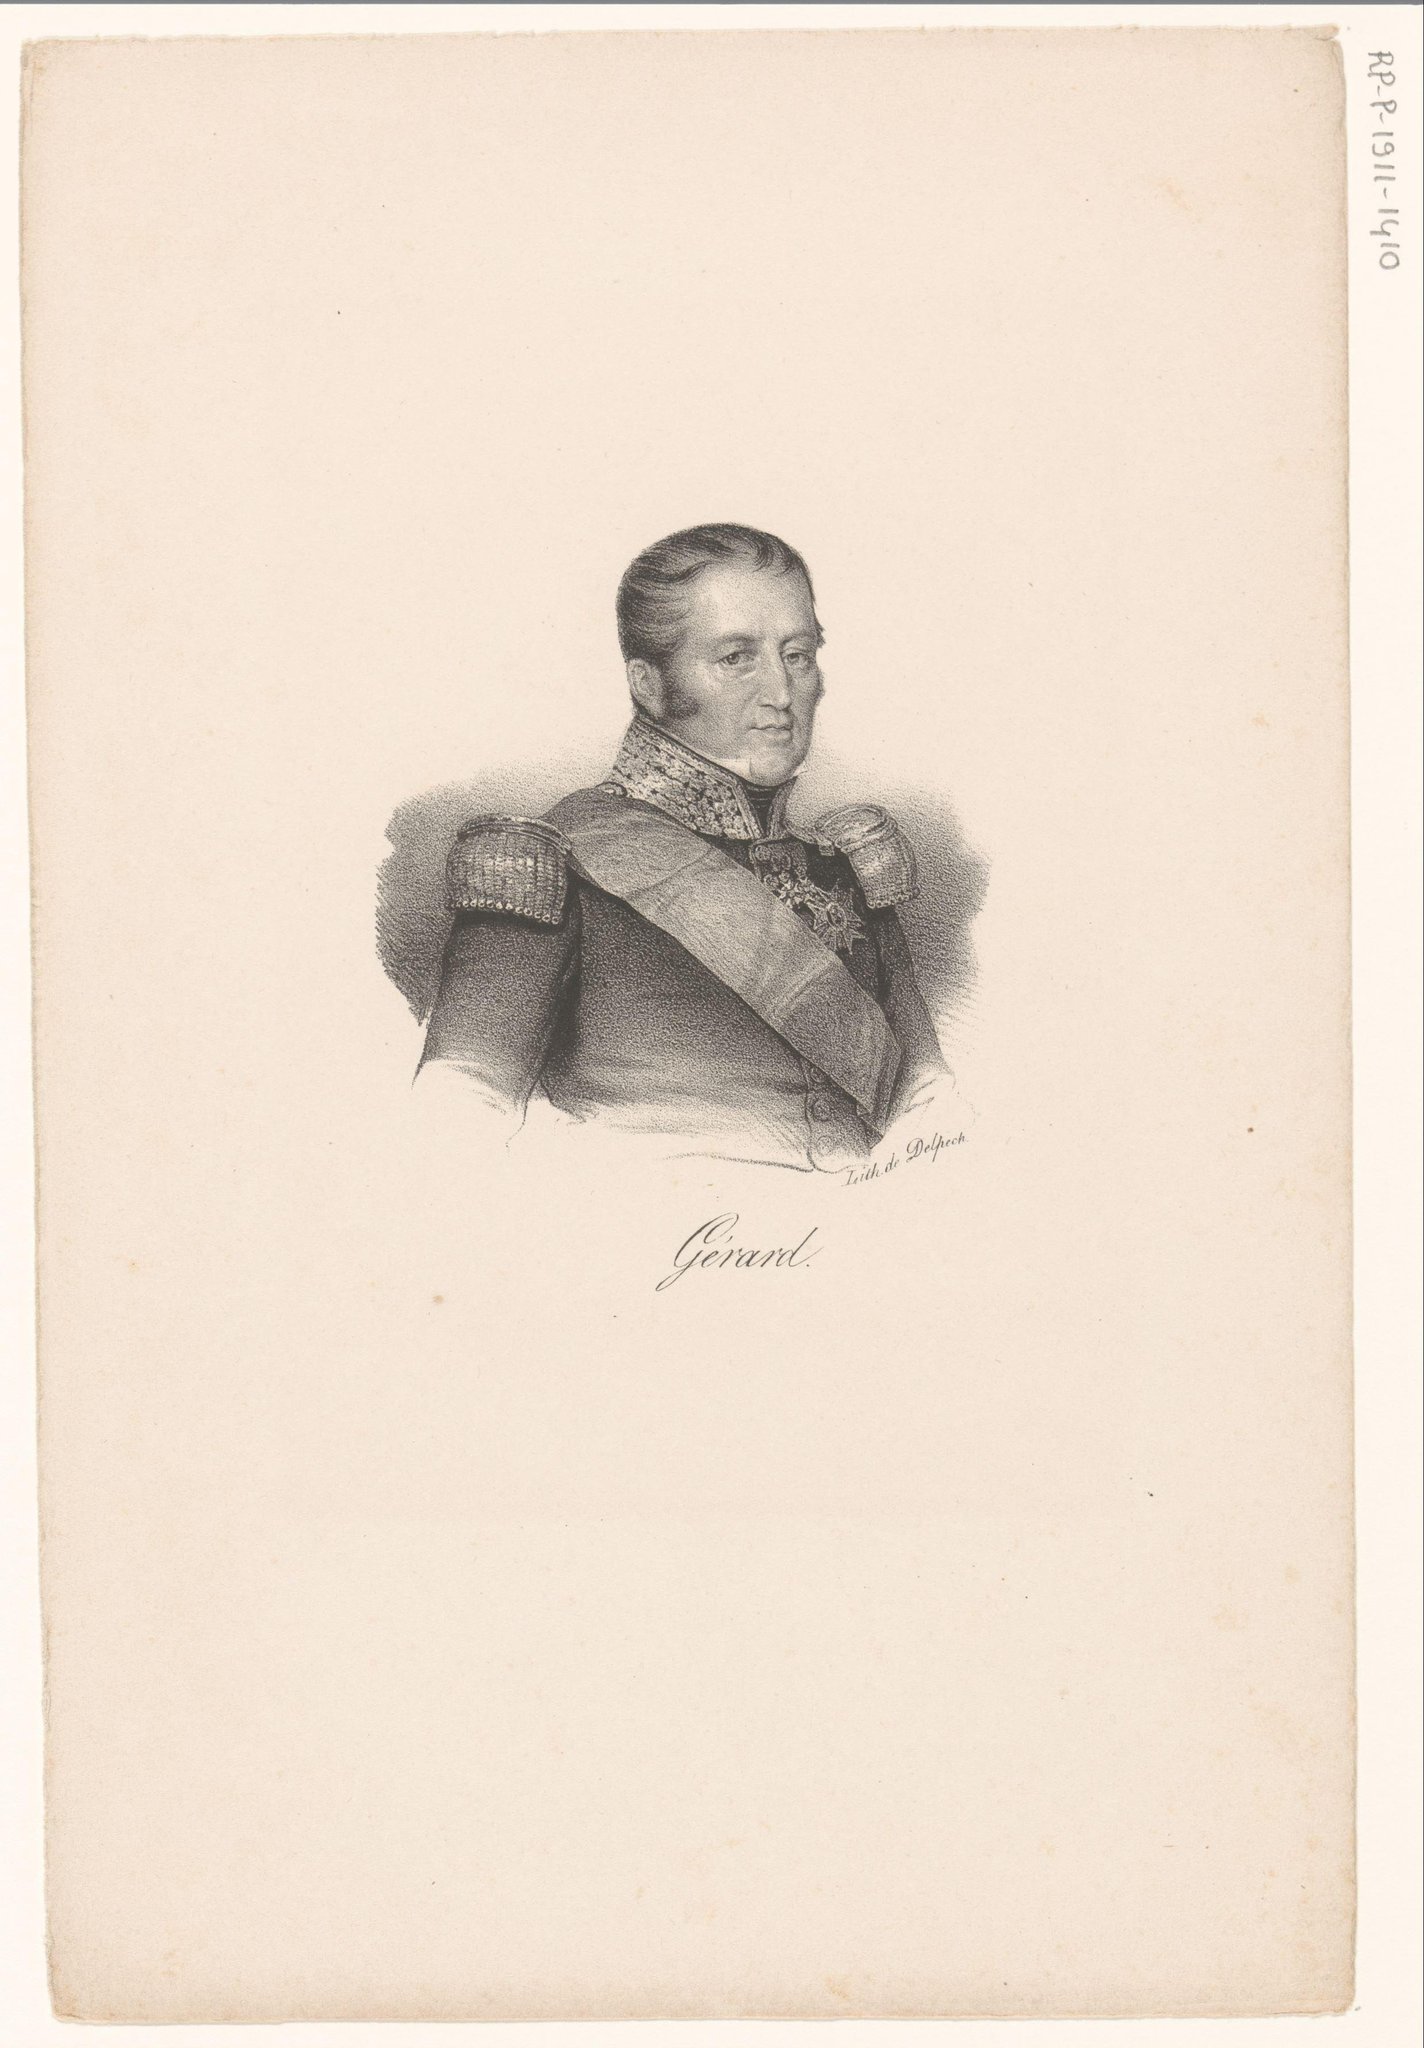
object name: print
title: Portret van Étienne Maurice Gérard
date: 1818-1842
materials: paper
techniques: lithograph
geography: paris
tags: historical persons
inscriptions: collector's mark: Lugt 2228a